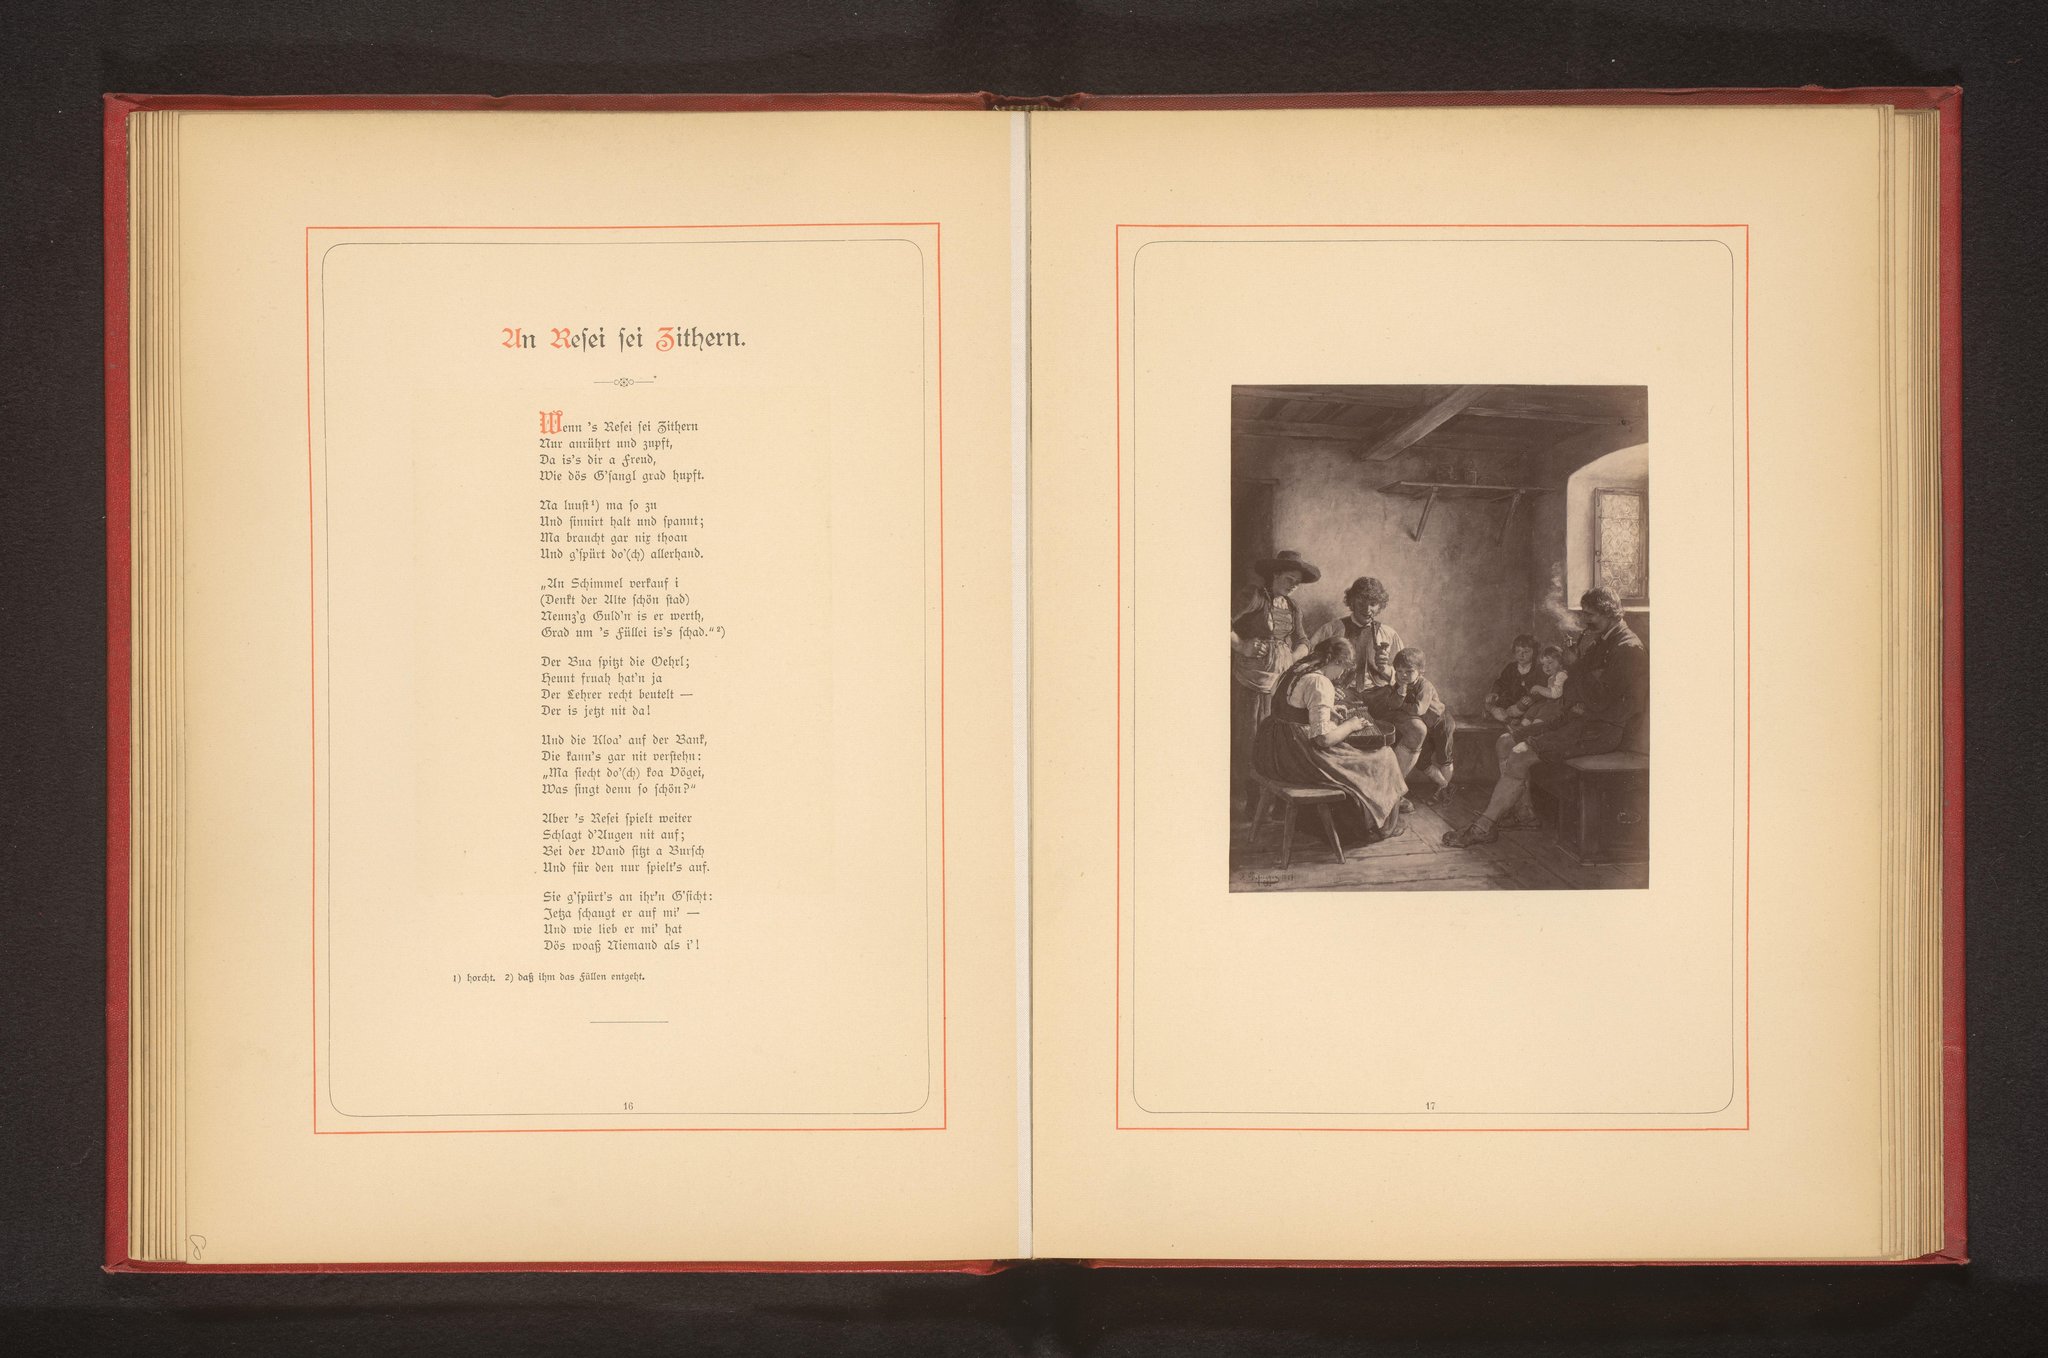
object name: page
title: Fotoreproductie van een schilderij, voorstellende een gezelschap luistert naar een citerspelend meisje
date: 1879-1883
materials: photographic support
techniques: albumen print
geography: germany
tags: making music; musician with instrument, interior ~ representation of a building, dulcimer, zither